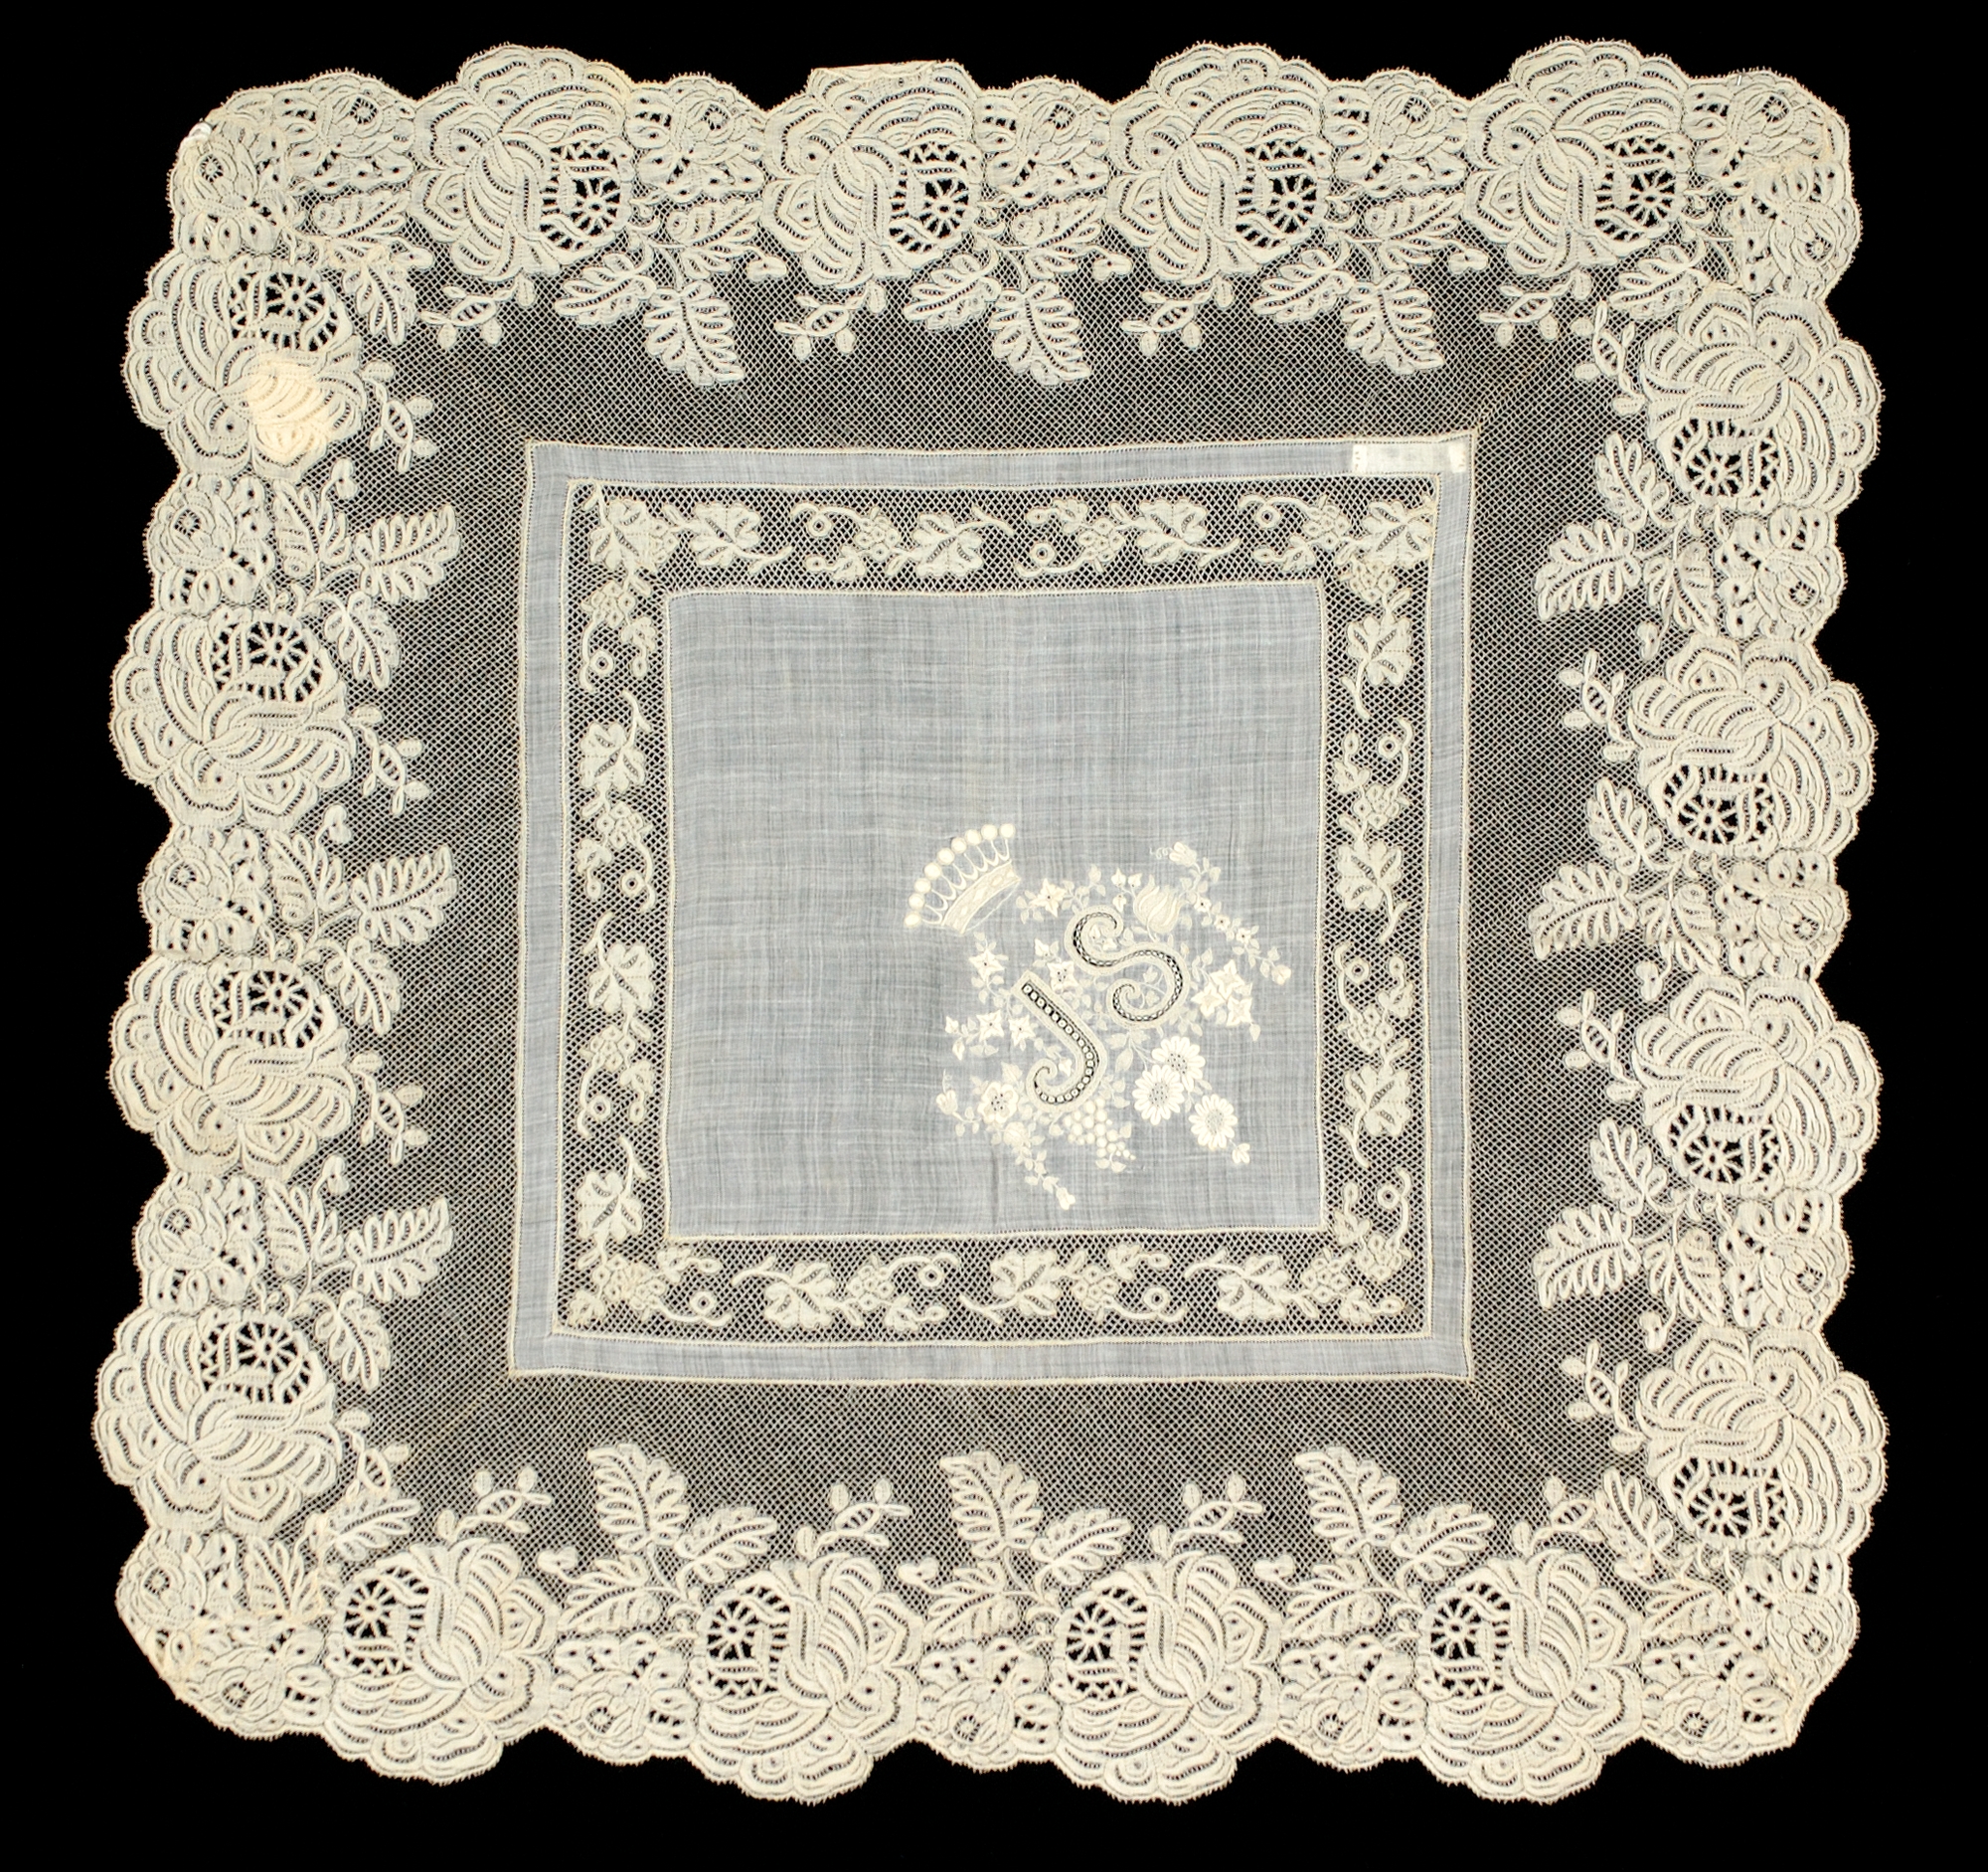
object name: handkerchief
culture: french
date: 1875-1899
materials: linen